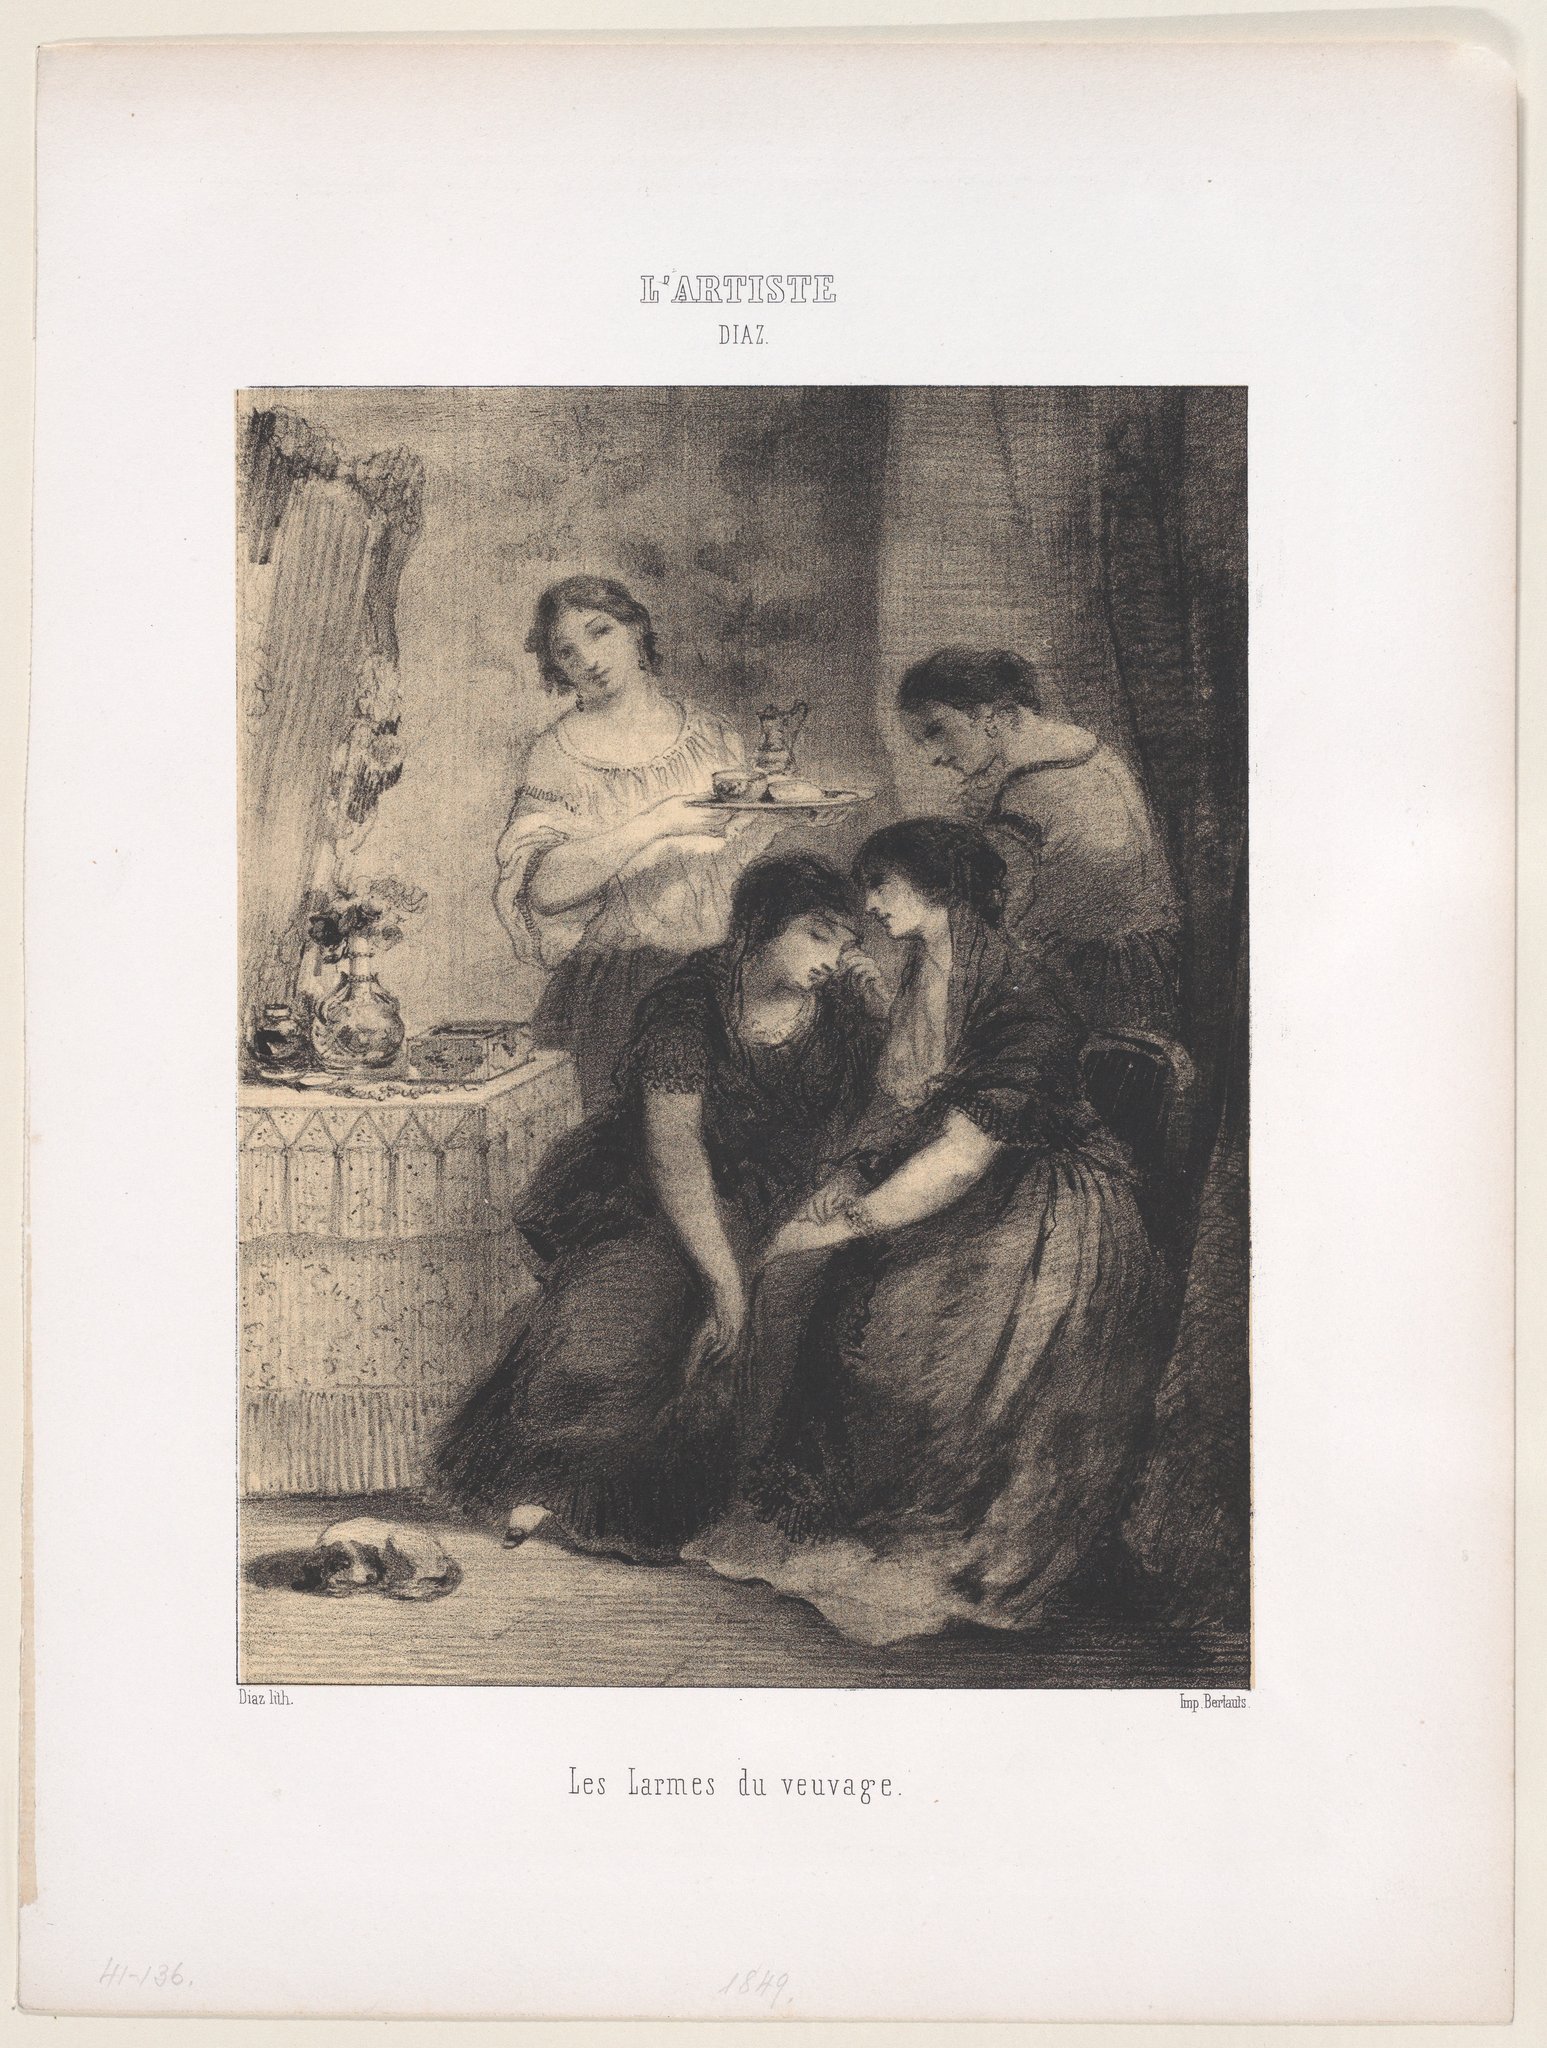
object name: print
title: Les Larmes du veuvage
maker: narcisse-virgile diaz de la peña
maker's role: artist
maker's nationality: french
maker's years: 1808-1876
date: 1830-1876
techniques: lithograph